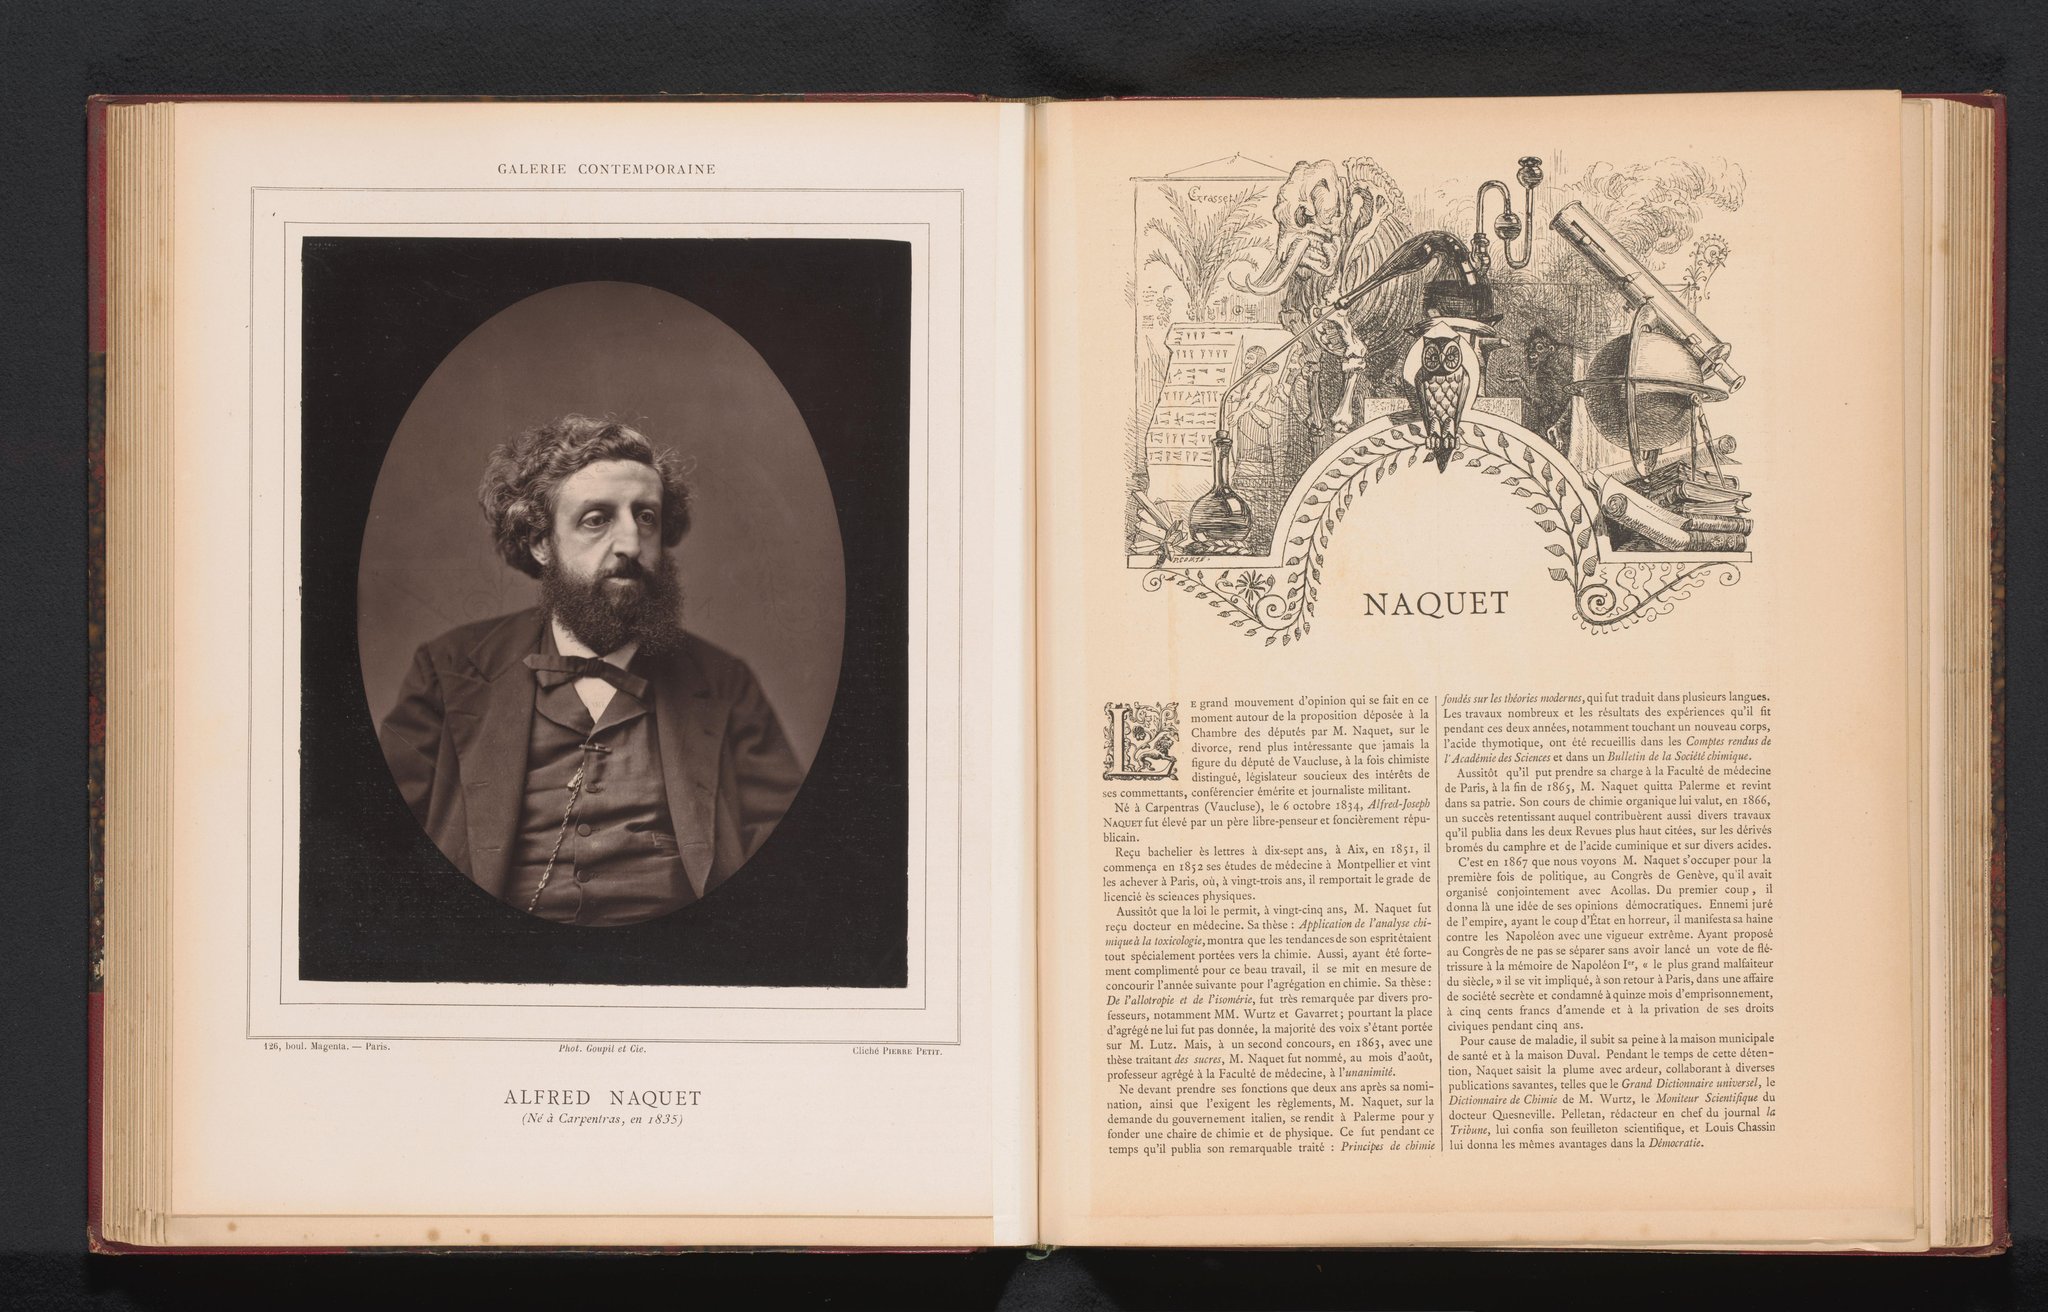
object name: page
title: Alfred Naquet (Ne a Carpentras, en 1835)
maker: pierre petit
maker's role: fotograaf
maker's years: 1832-1909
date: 1874-1879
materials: paper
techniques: woodburytype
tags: paris, politician, adult man, historical persons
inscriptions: inscription: ‘Galerie Contemporaine/ 126, boul. Magenta. - Paris./ (Né a Carpentras, en 1835)’